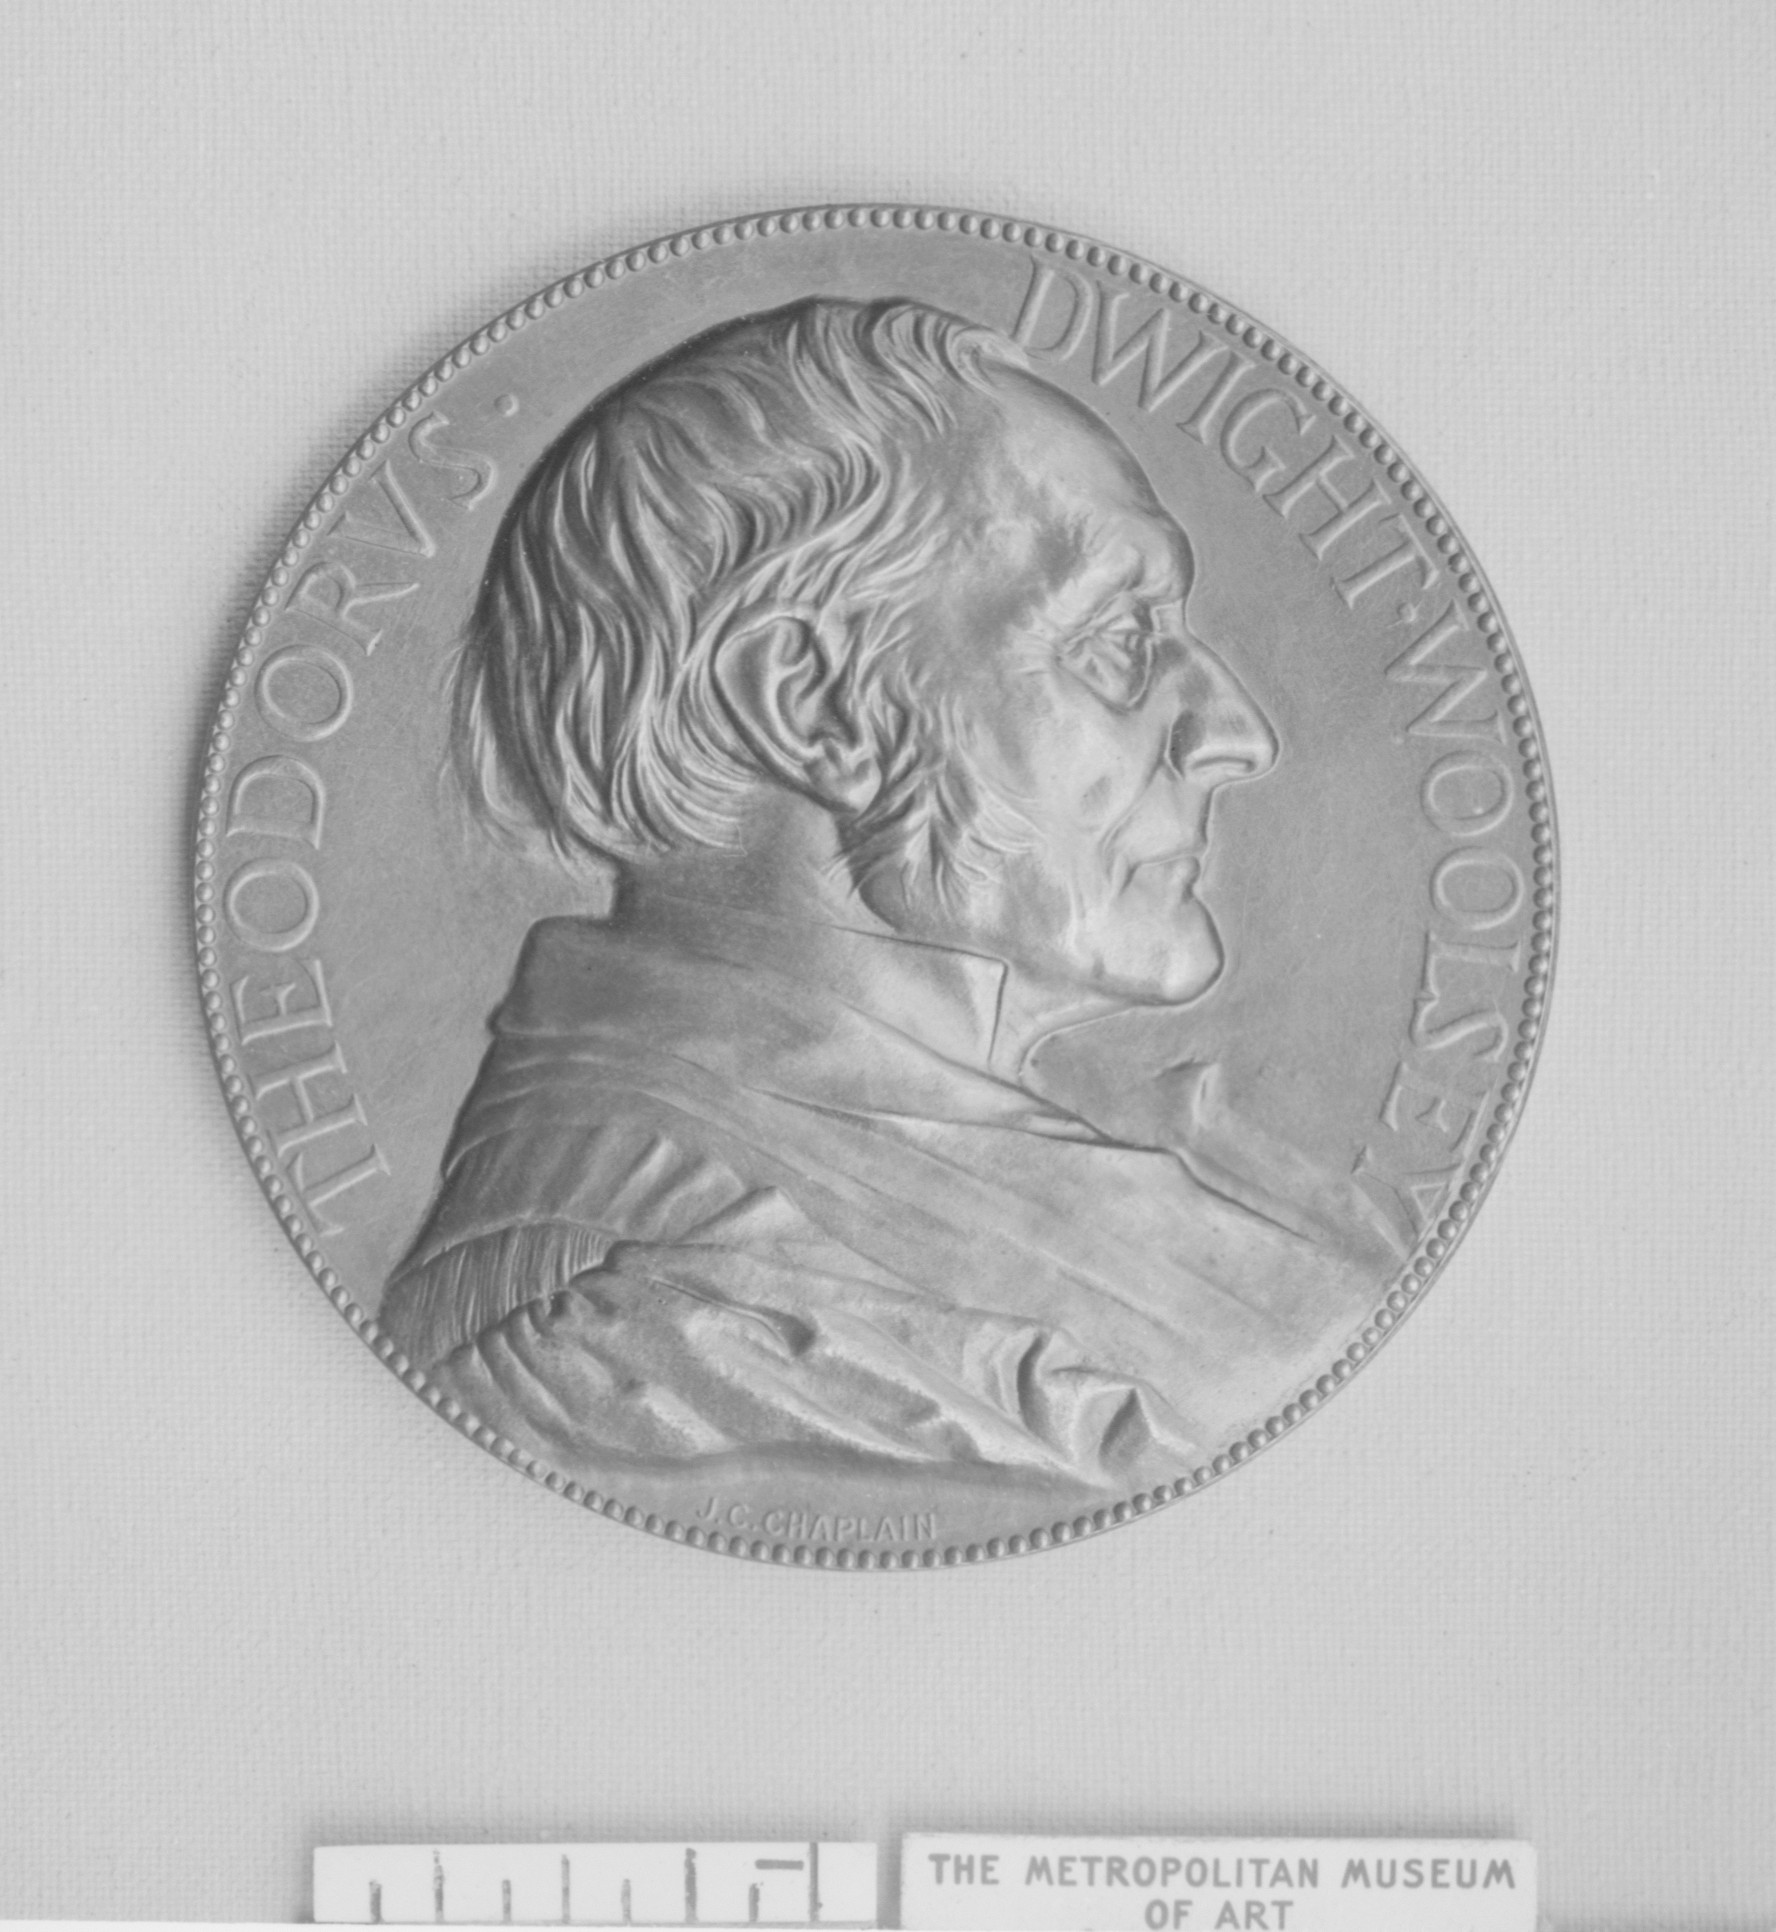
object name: medal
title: In memoriam of President Woolsey of Yale University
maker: jules-clément chaplain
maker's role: artist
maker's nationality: french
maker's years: 1839-1909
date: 1882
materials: bronze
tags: men,profiles